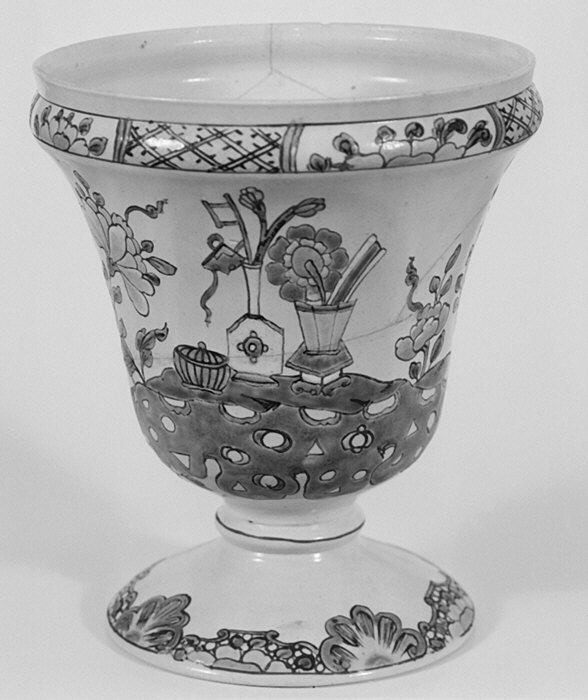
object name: vase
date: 1755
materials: stoneware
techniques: salt glaze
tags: flowers